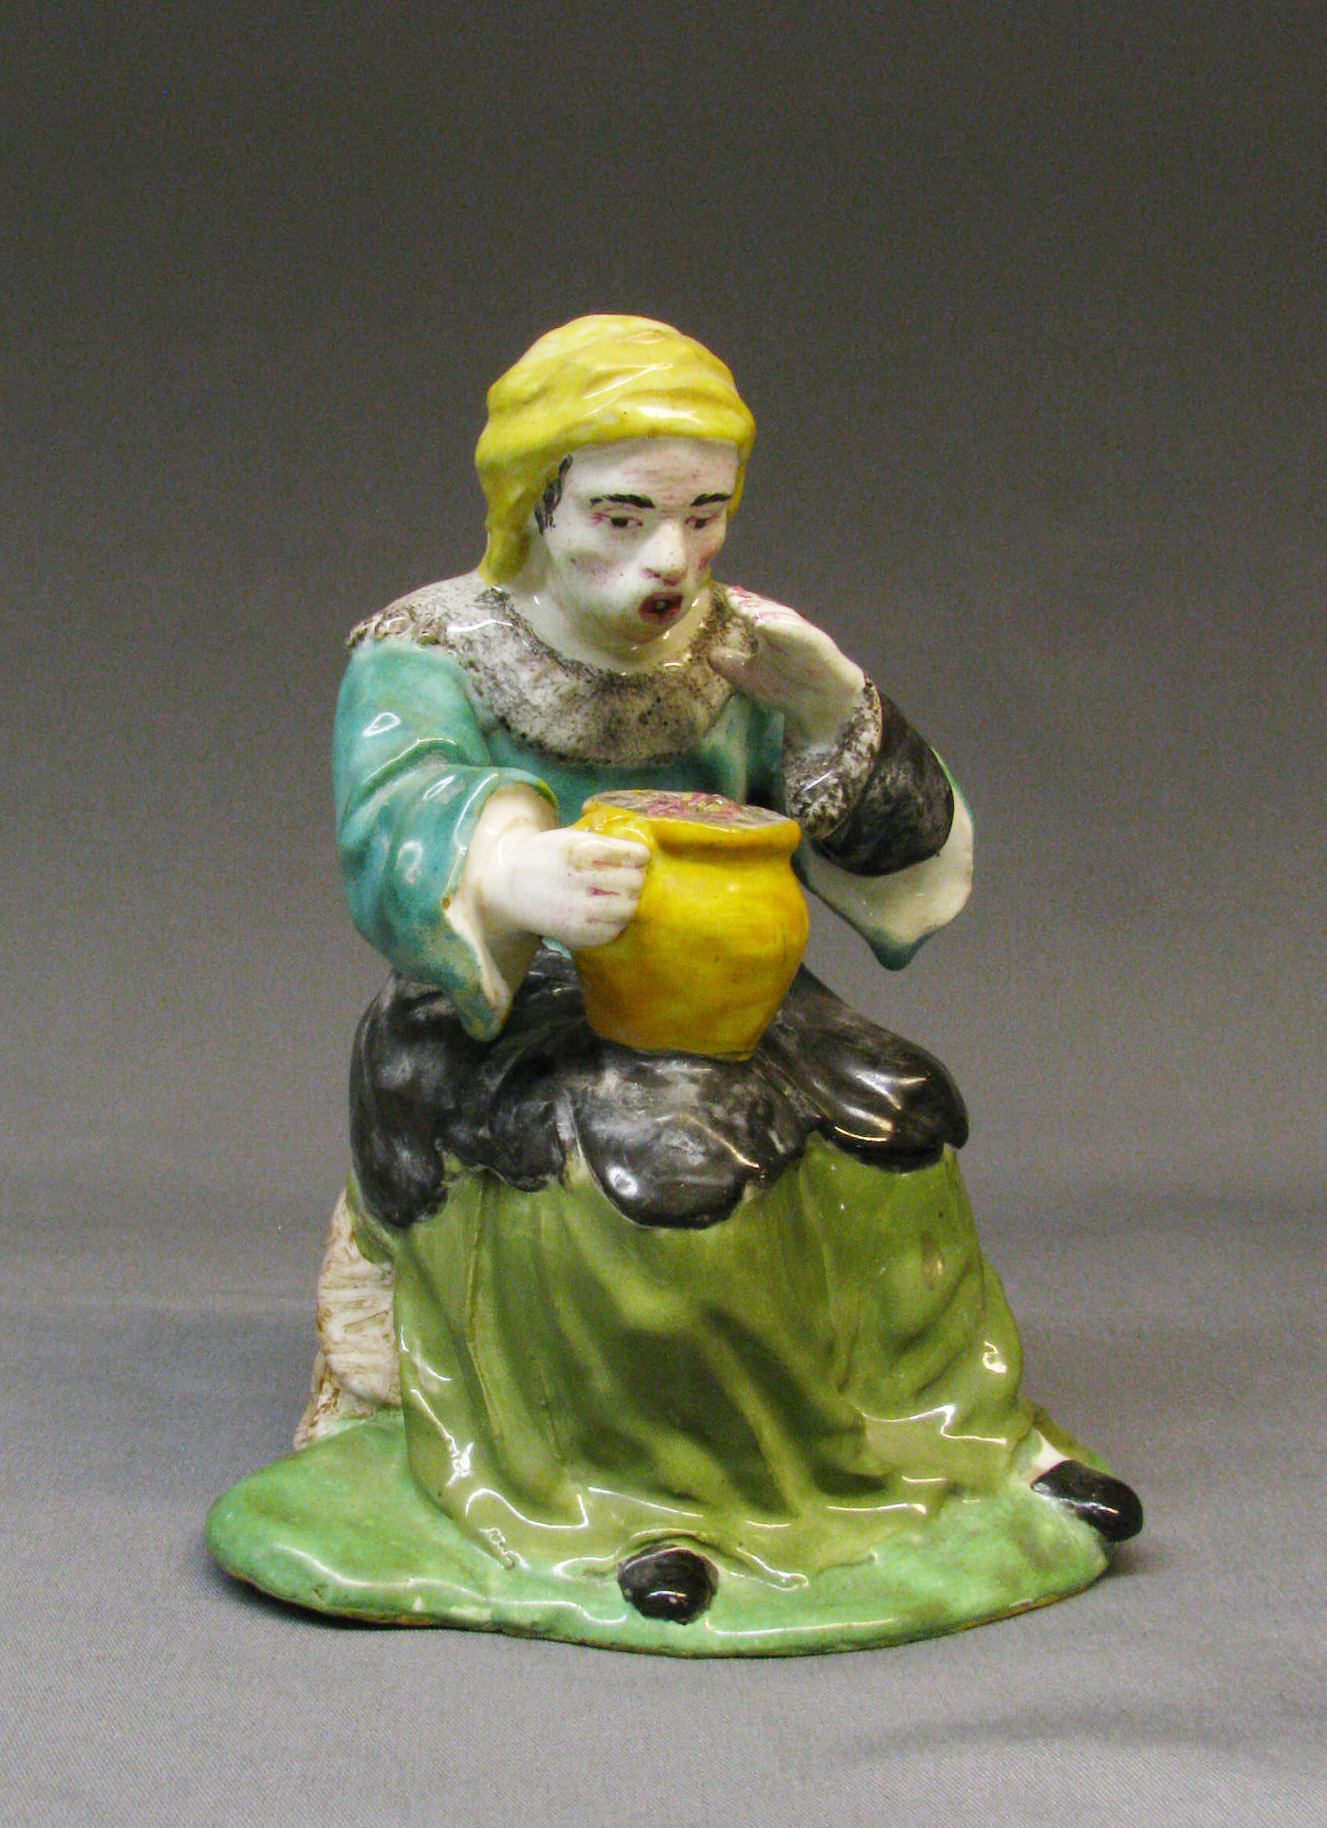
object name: figure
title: Seated peasant woman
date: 1701-1733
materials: earthenware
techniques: glazing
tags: women